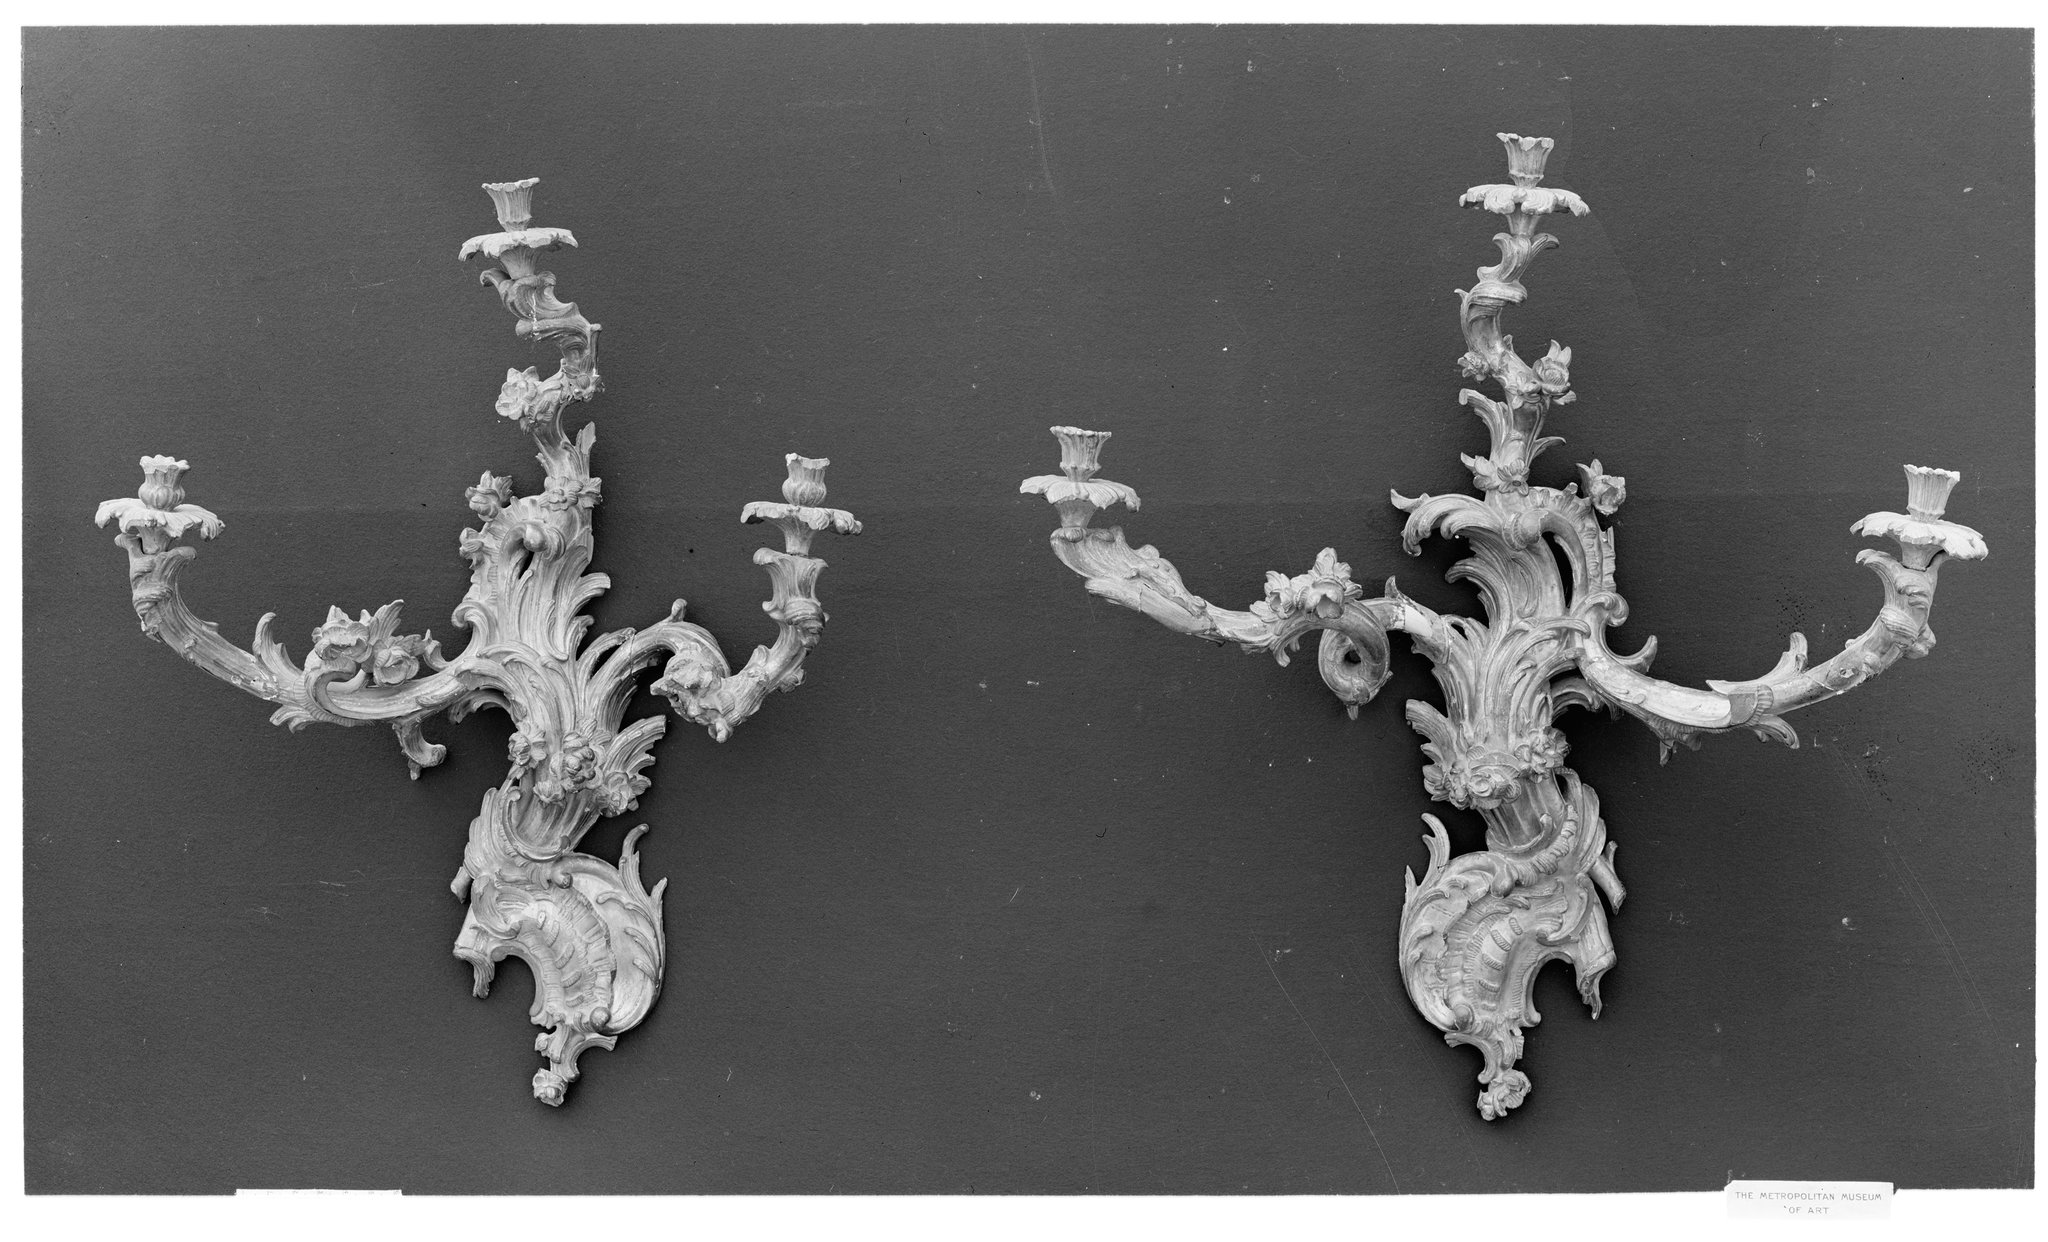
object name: wall light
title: Wall light (candelabrum appliqué) (one of a pair)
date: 1735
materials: wood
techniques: carving, gilding